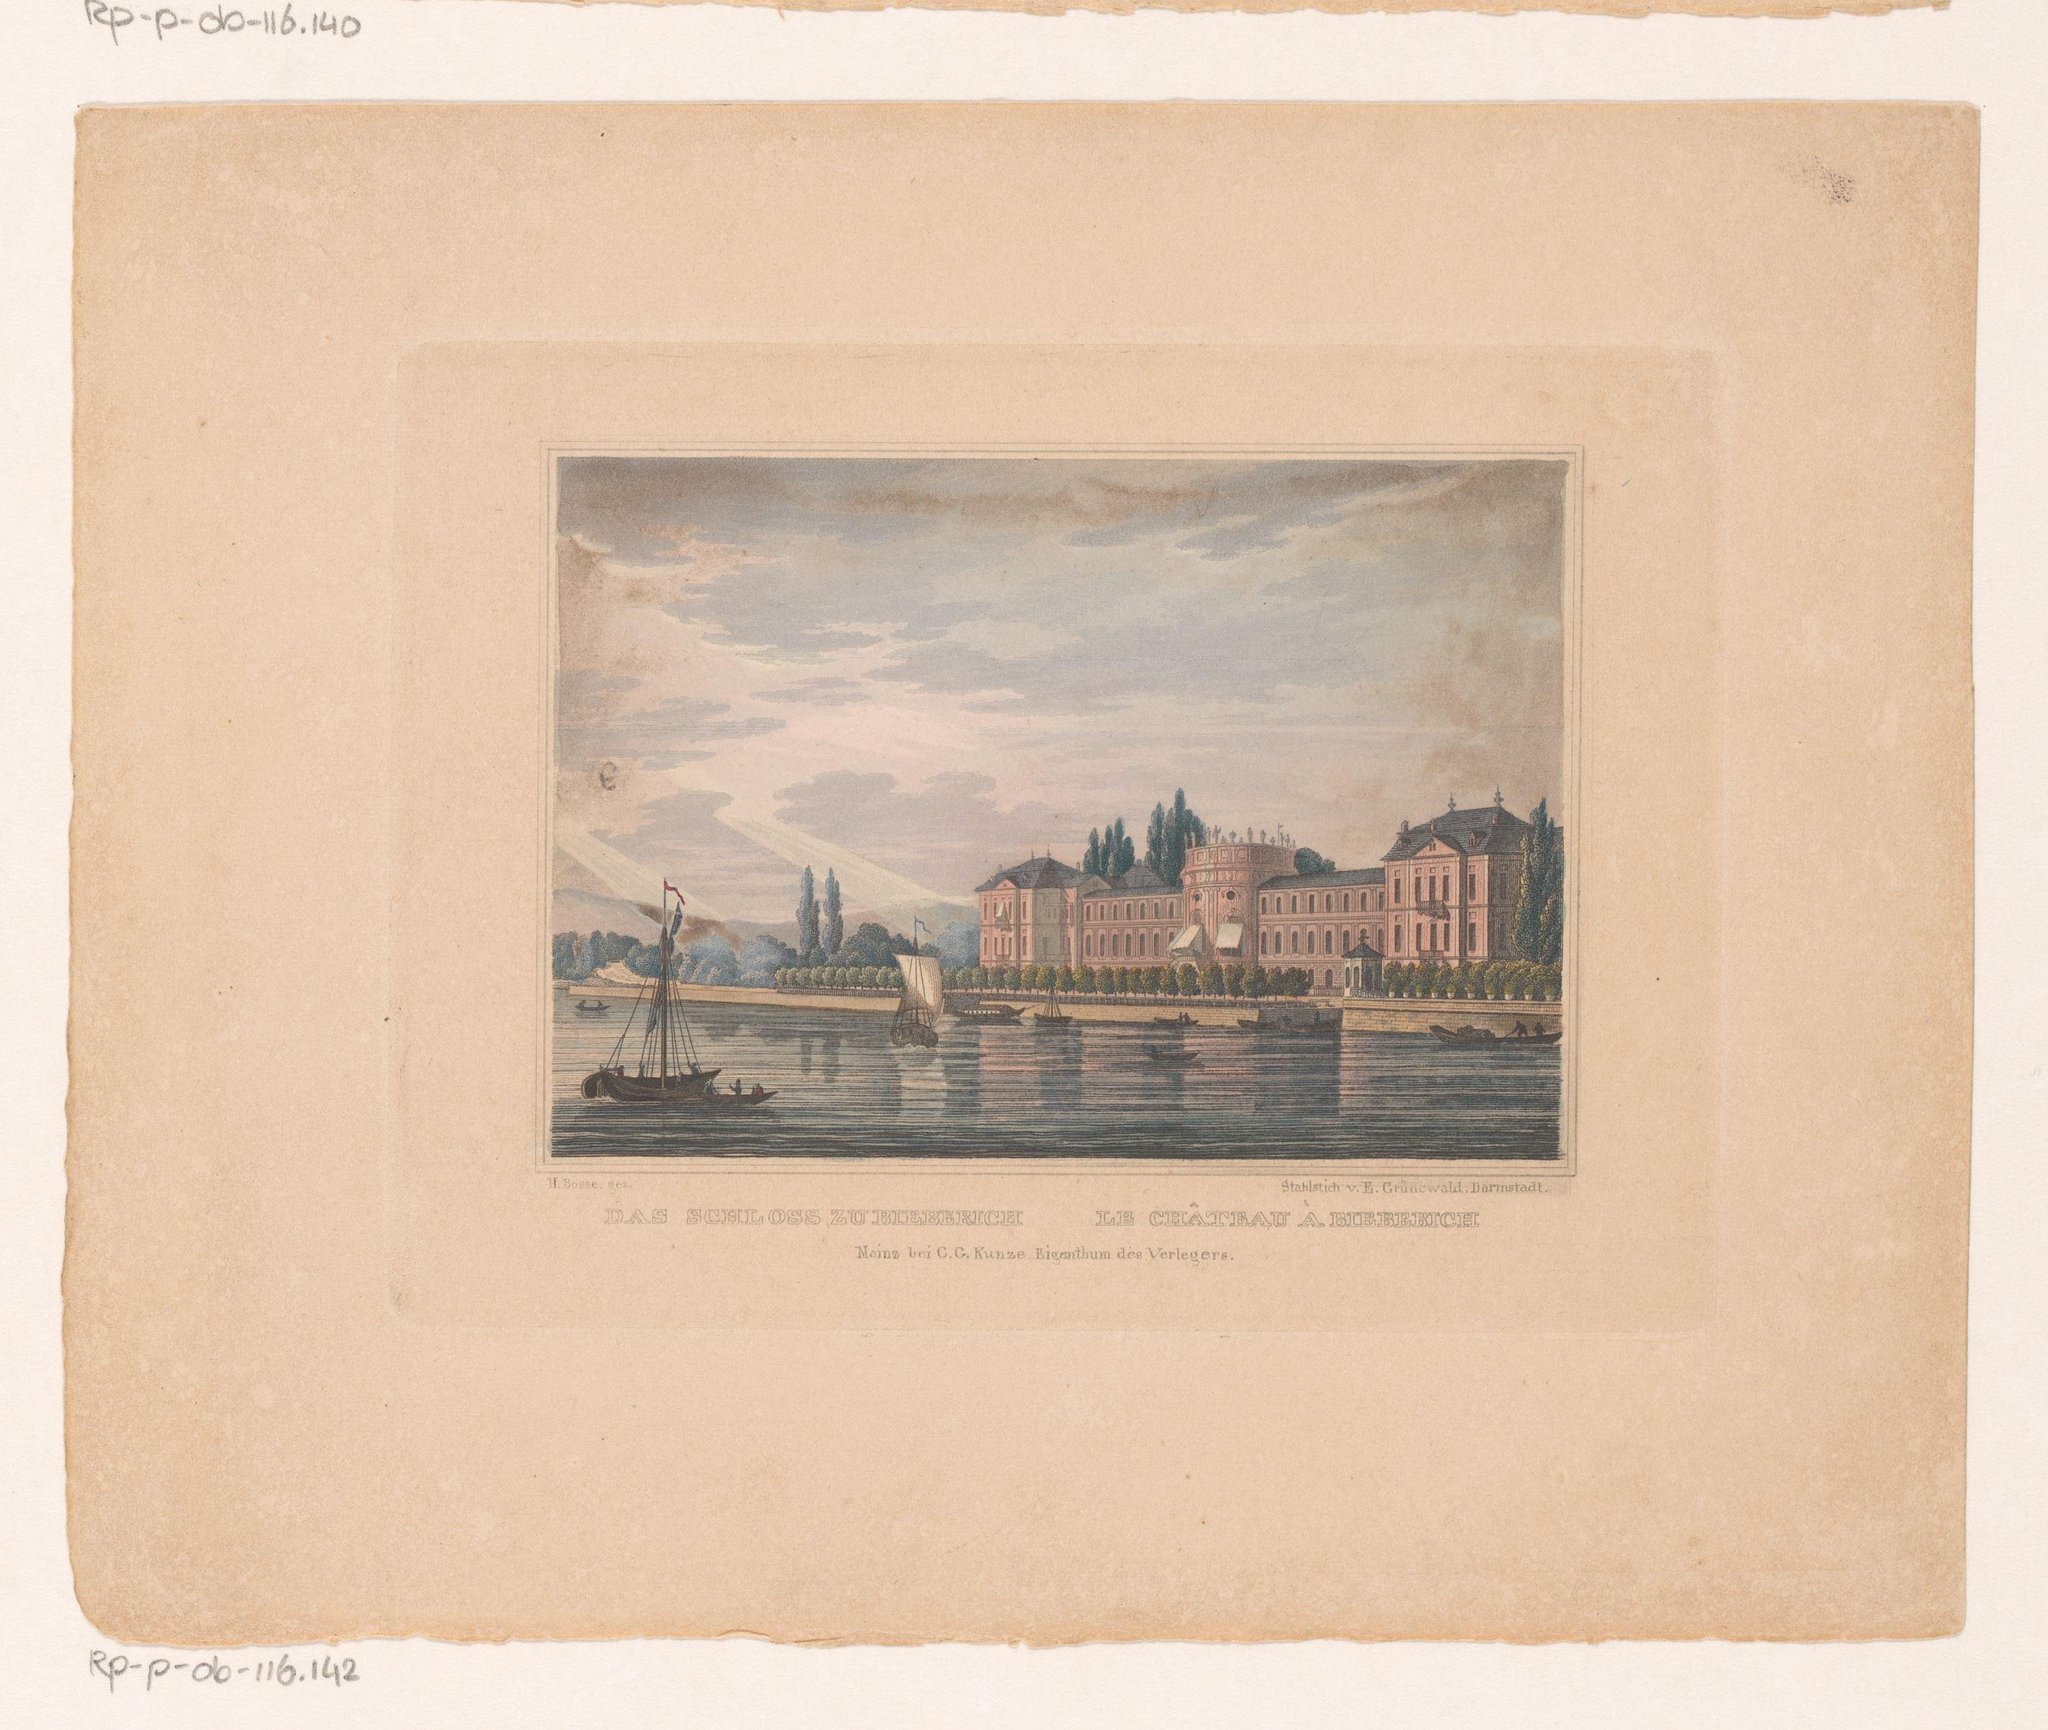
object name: print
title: Gezicht op kasteel Bieberich bij Wiesbaden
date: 1811-1848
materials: paper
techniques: hand coloring, engraving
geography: mainz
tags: landscape with tower or castle, ships (in general) - cc - more than one ship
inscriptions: collector's mark: Lugt 2228